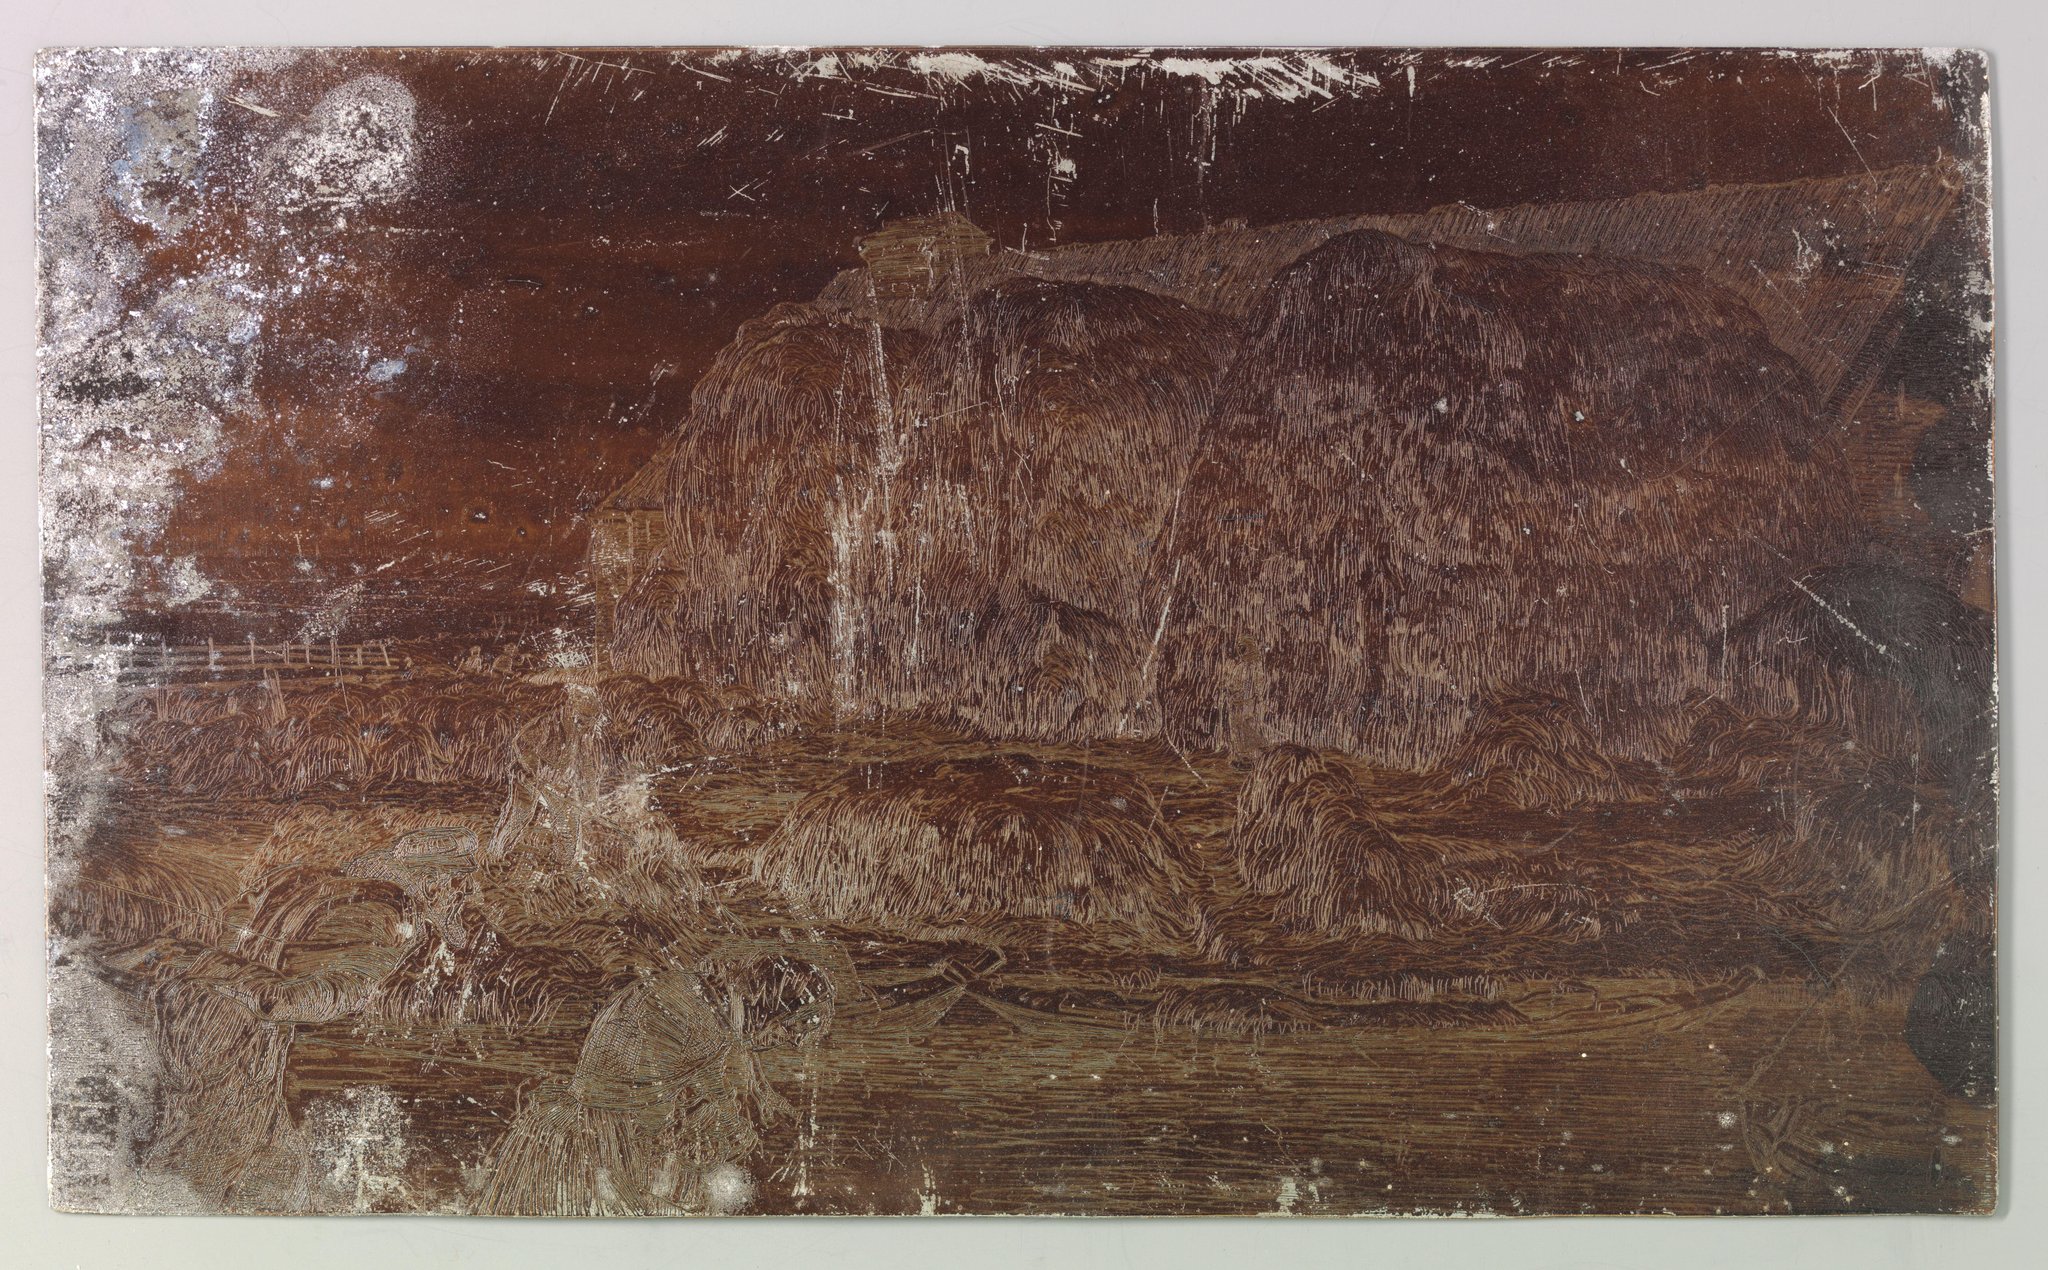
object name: zinkplaat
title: Hooischuren aan het jaagpad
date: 1895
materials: zinc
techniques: etching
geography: netherlands